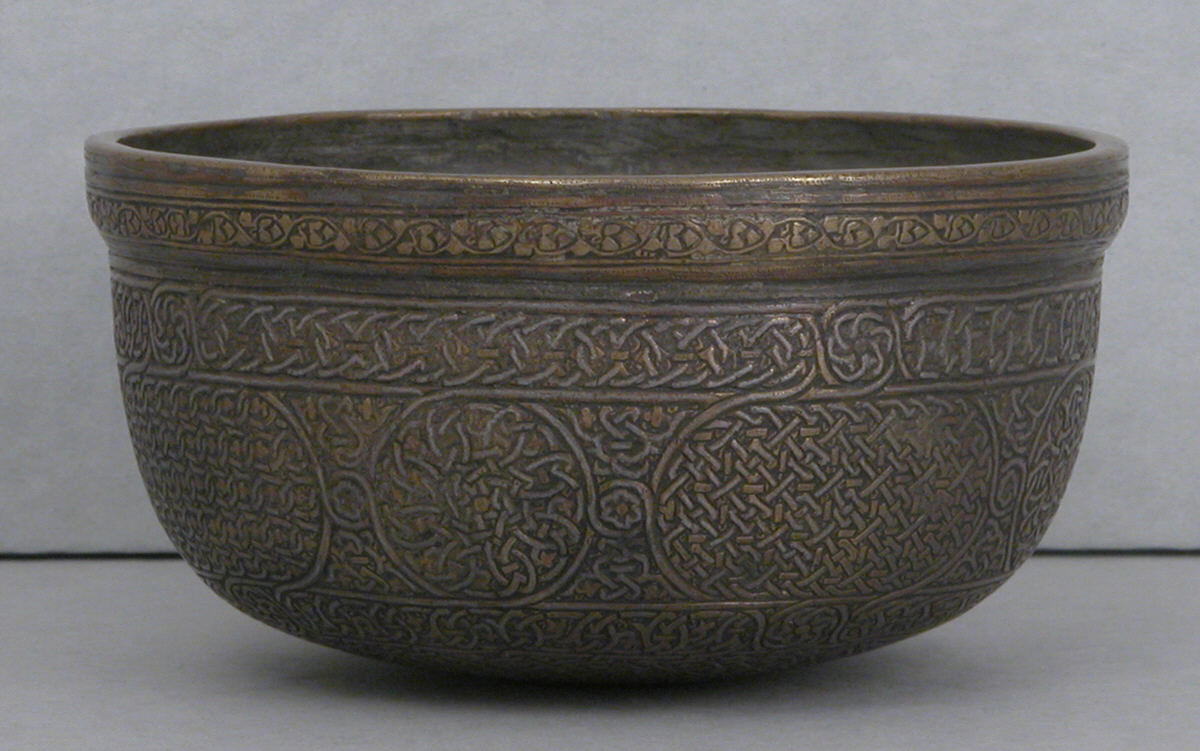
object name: bowl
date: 1401-1500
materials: brass, silver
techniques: inlay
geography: syria